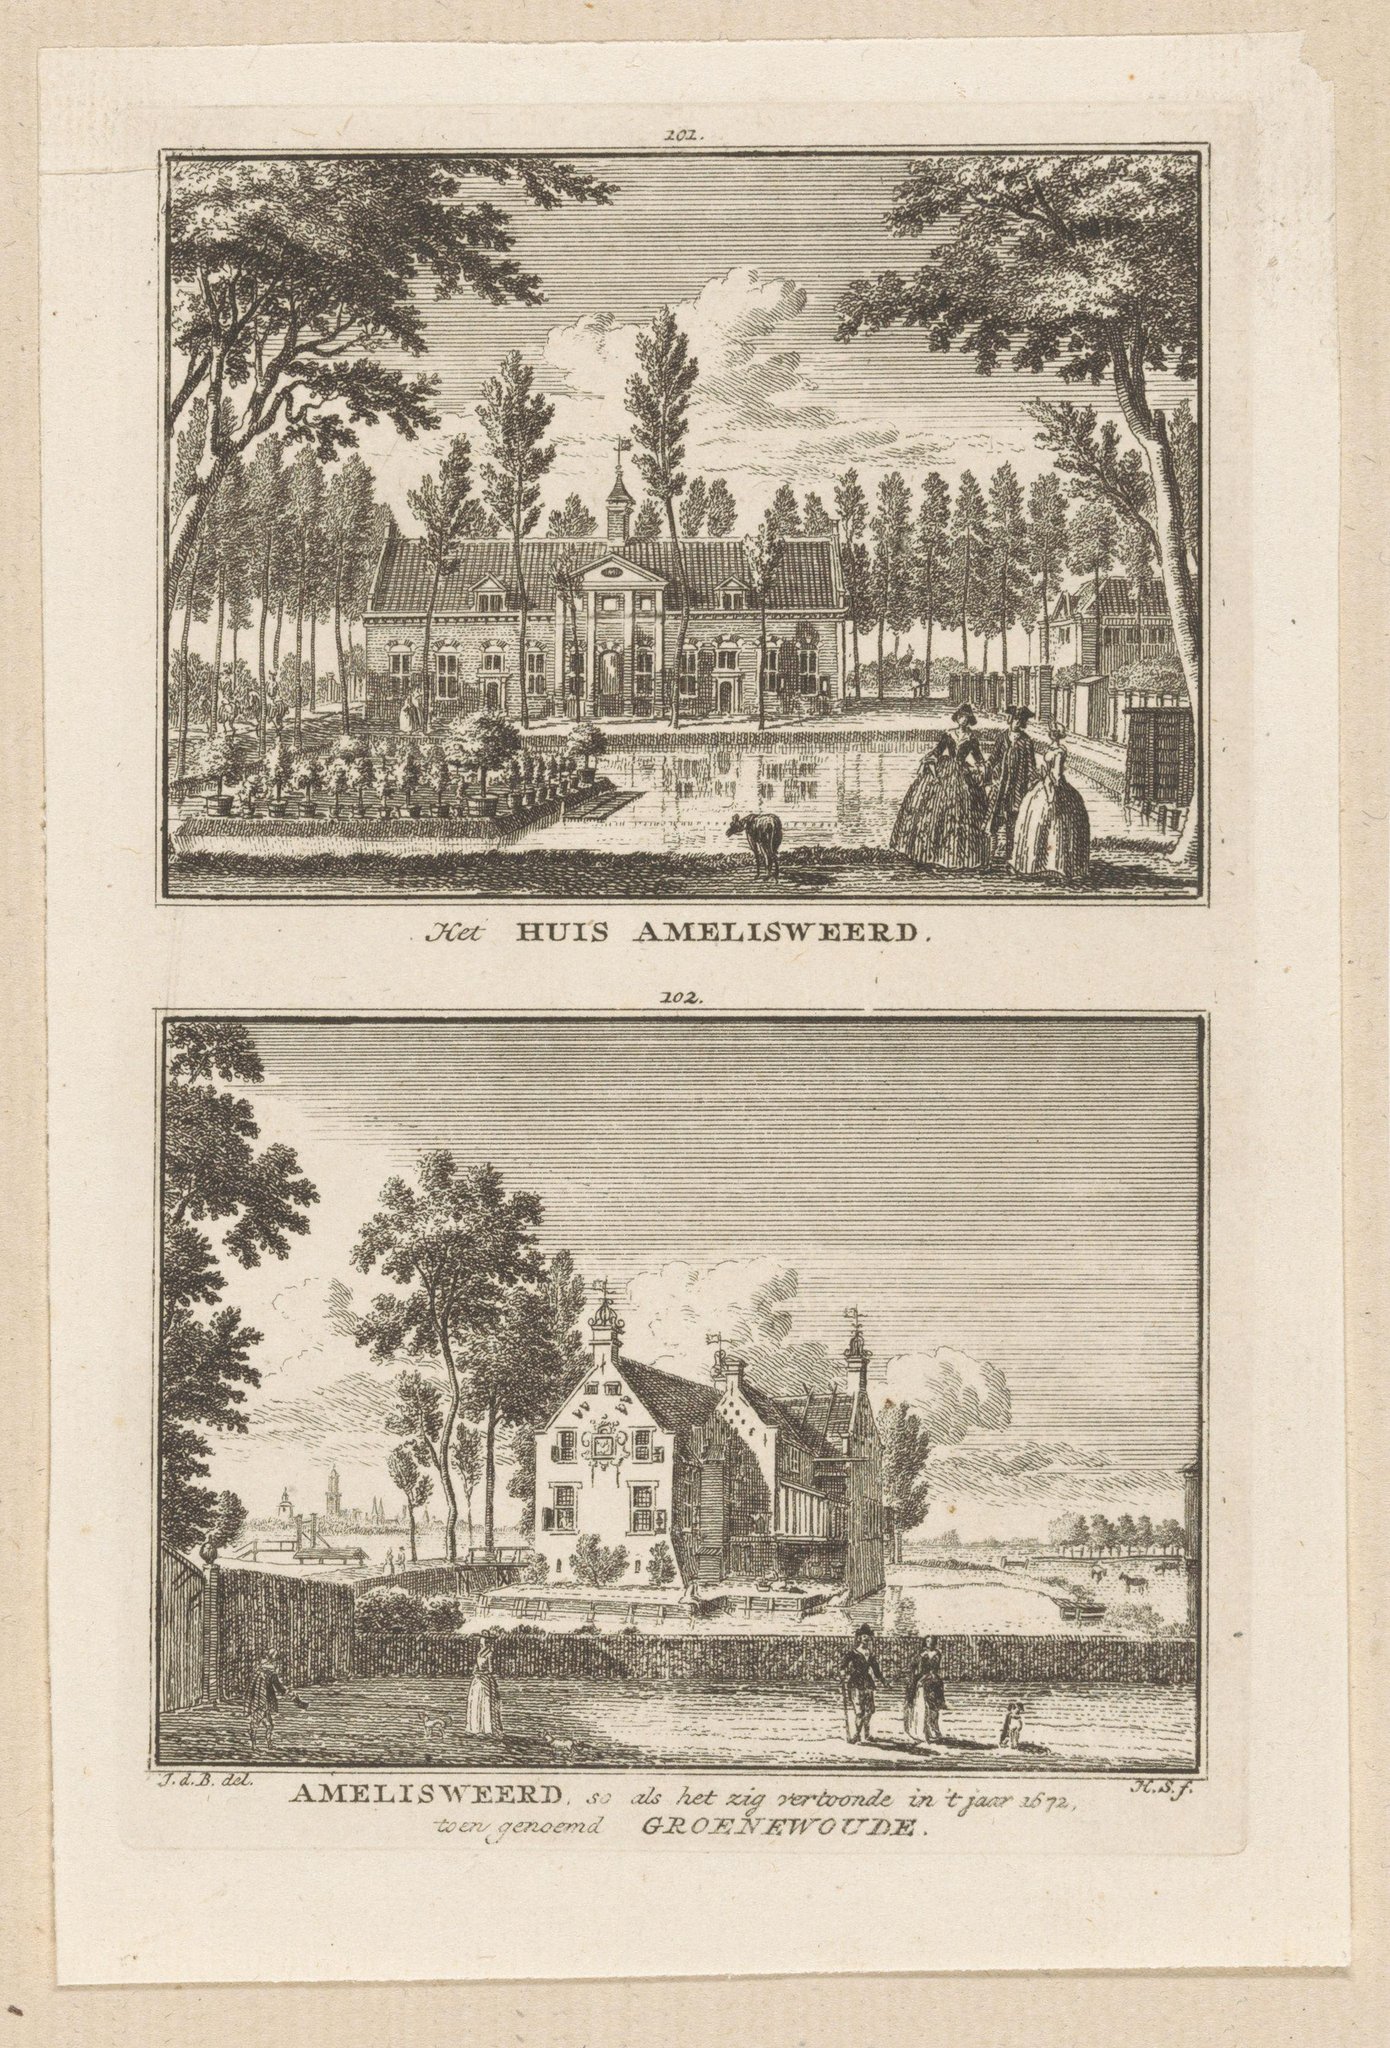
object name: book illustration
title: Het huis Amelisweerd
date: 1773-1792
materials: paper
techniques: engraving, etching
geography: haarlem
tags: castle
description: Prent ook gebruikt in: Het verheerlykt Nederland of kabinet van hedendaagsche gezigten van steden, dorpen (…). 9 delen. Amsterdam: Isaak Tirion en weduwe Isaak Tirion, 1745-1774, dl. 7, 8 of 9 (weduwe Isaak Tirion, 1773-1774), ill. 101 en 102. Of in: Nederlandsche tafereelen; of eene keurige verzameling van negen honderd fraaije gezigten van steden, dorpen, sloten, oudheden (….). 9 delen. Amsterdam: Jan de Groot, 1792, dl. 7, 8 of 9, ill. 101 en 102. Uit welke druk het huidige exemplaar precies komt is niet na te gaan.